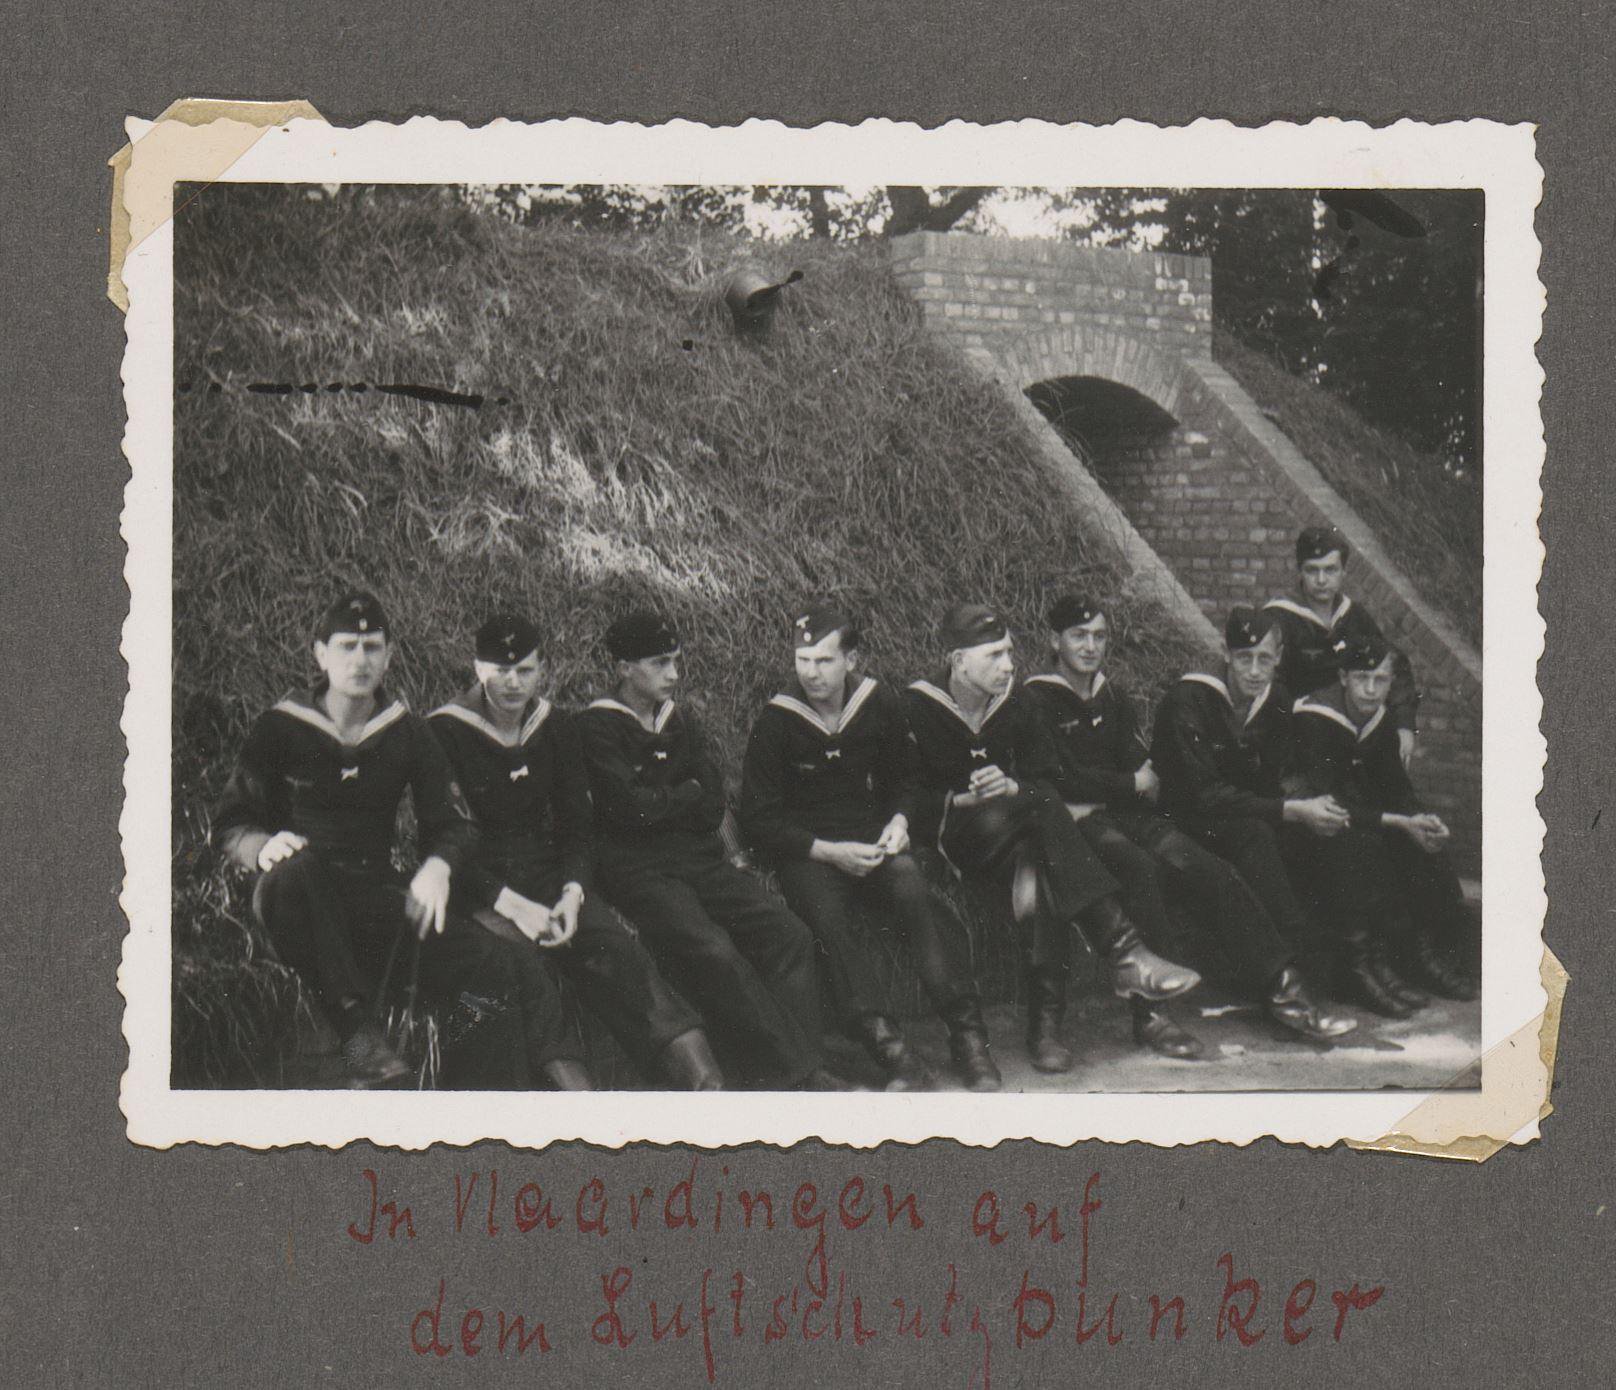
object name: photograph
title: Militairen in uniform bij een bunker te Vlaardingen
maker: Anonymous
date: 1941-1945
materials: paper, photographic support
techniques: gelatin silver print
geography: vlaardingen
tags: historical persons, the soldier; the soldier's life, (military) uniforms, shelter ~ military service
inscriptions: annotation: ‘In Vlaardingen auf/ dem Luftschutzbunker’